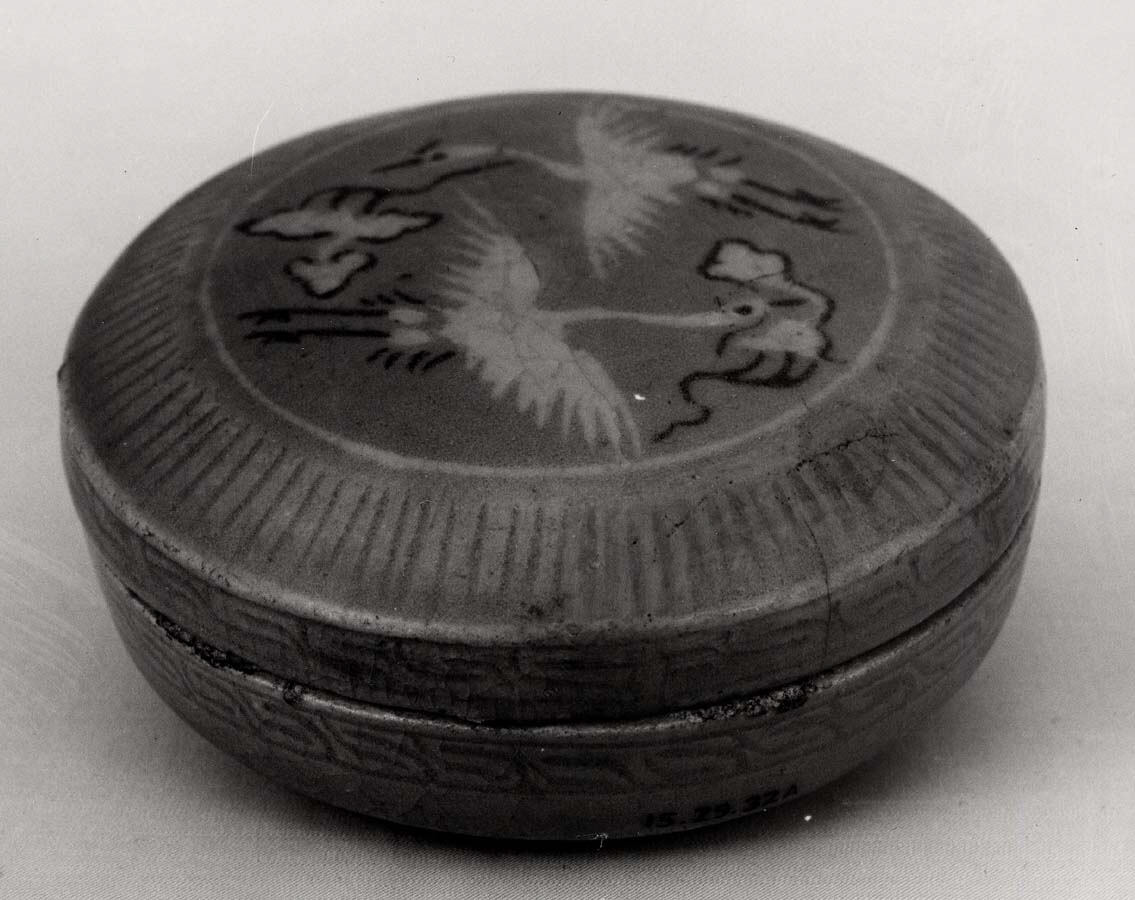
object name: box with cover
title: Pigment Box with Cover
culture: korean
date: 1901-1933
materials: ceramic glaze, glaze, stoneware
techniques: inlay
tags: birds